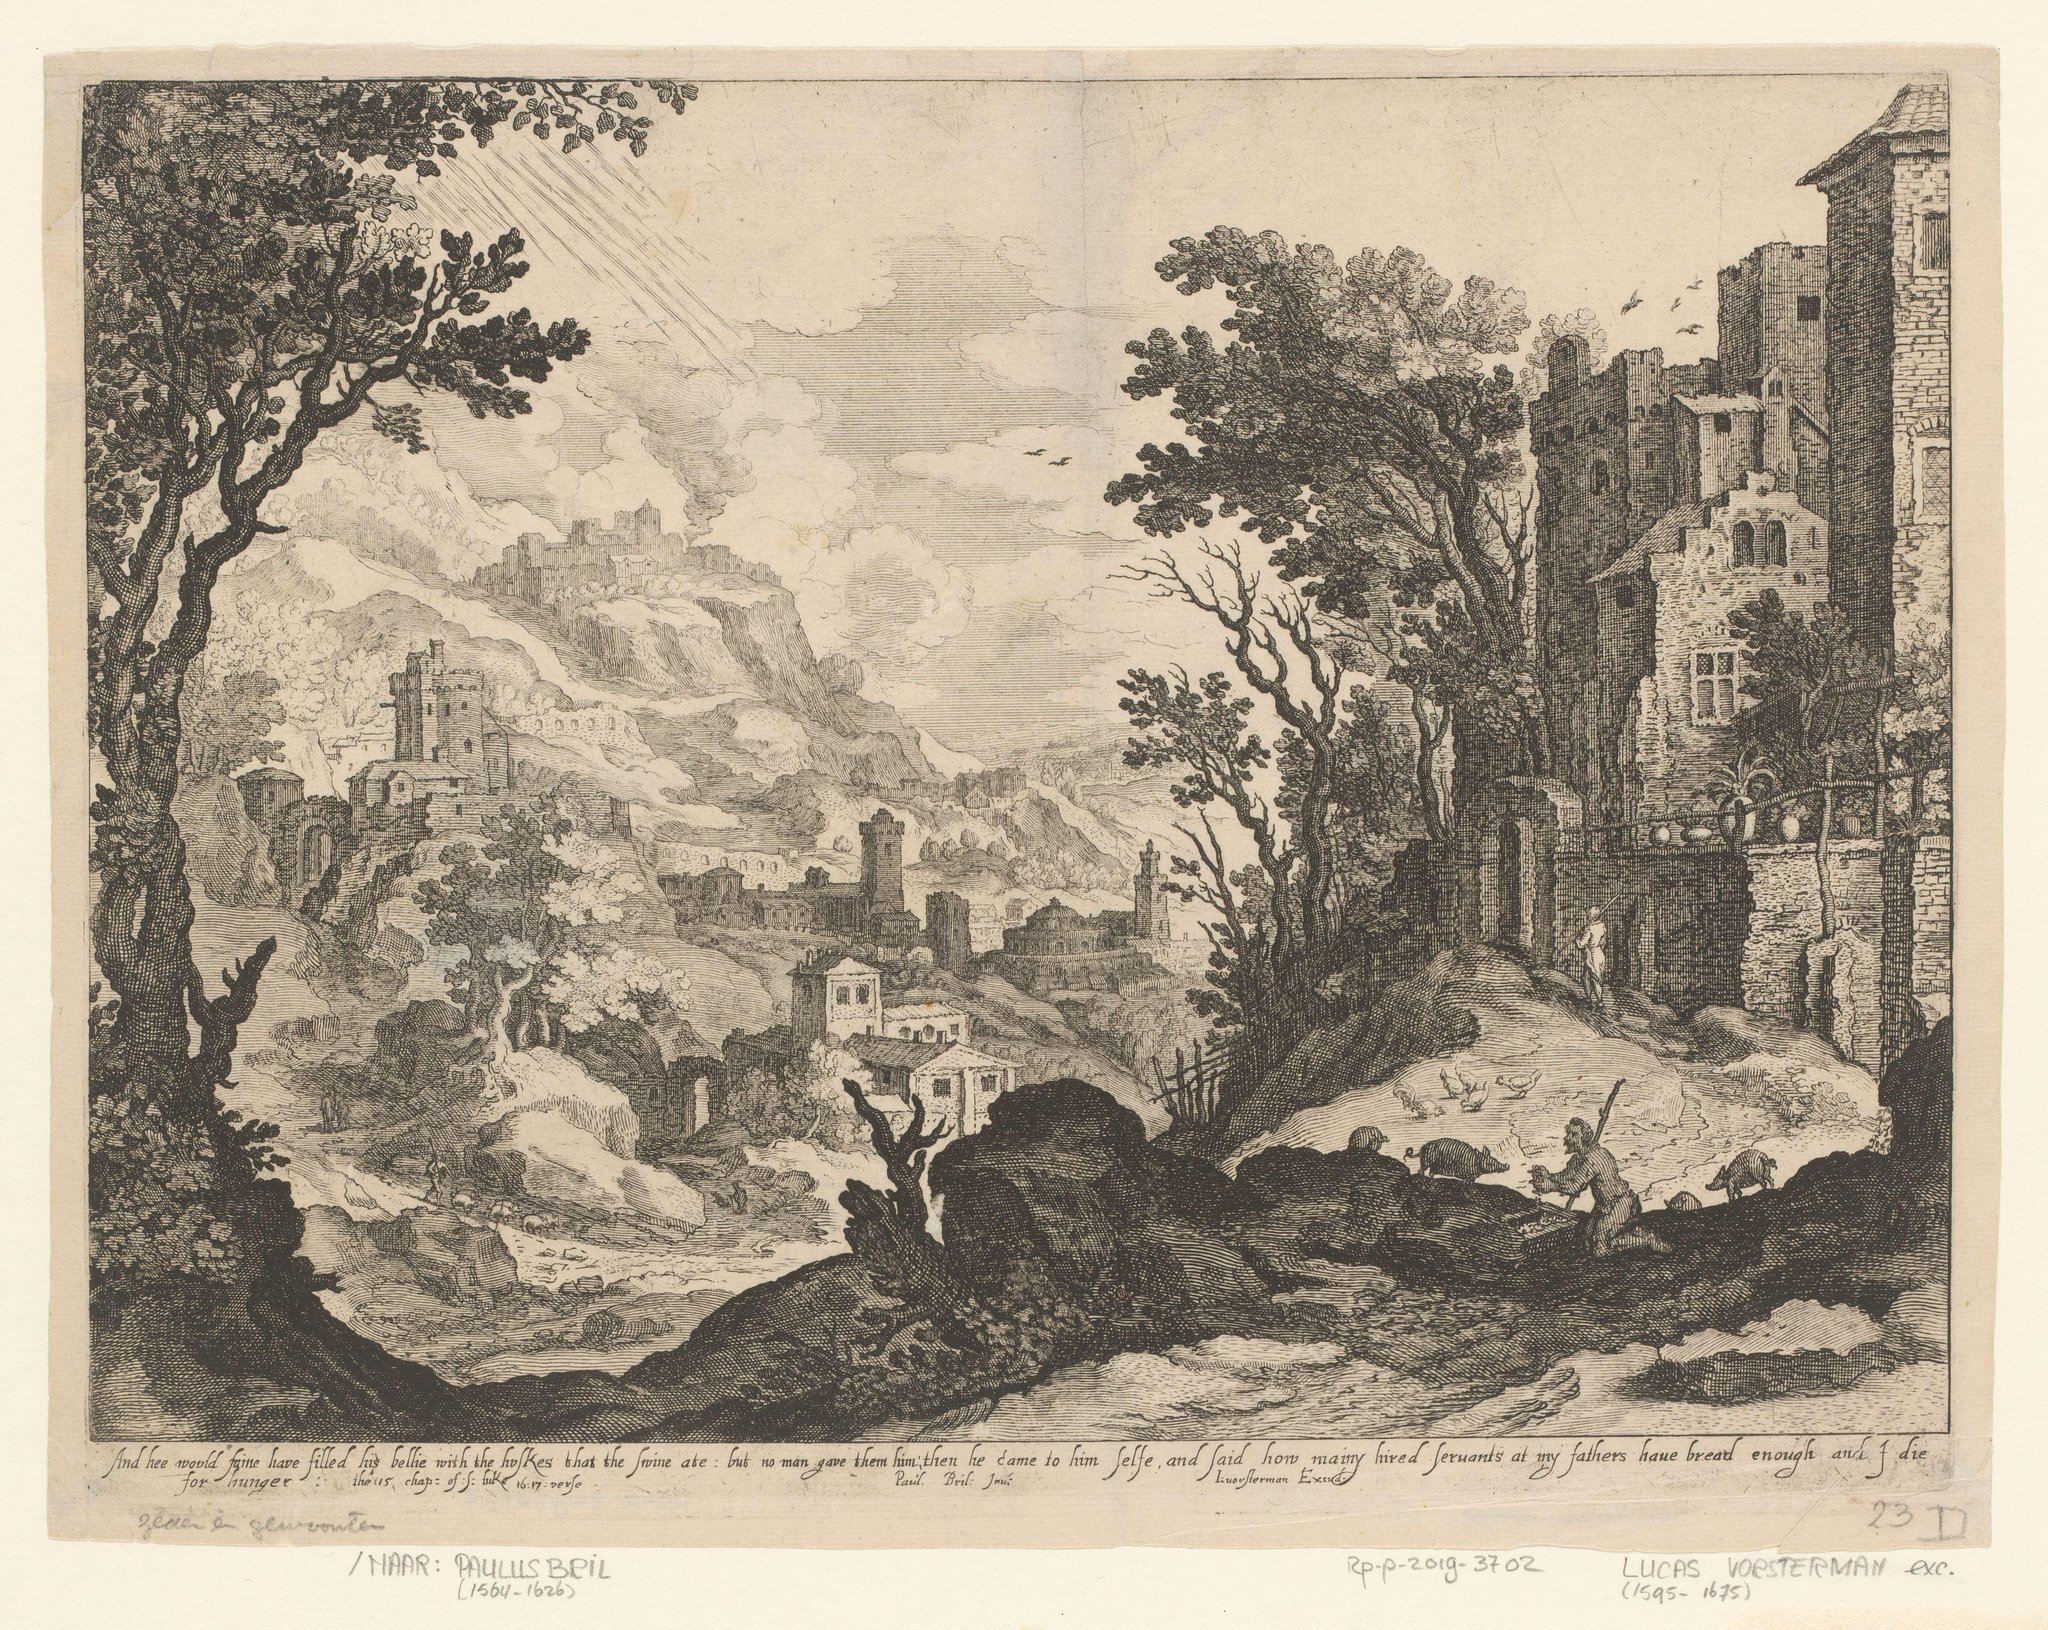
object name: print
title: Landschap met de verloren zoon als zwijnenhoeder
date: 1650-1655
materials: paper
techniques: engraving, etching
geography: antwerp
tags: the parable of the prodigal son (luke 15:11-32)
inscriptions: collector's mark: Lugt 2228, collector's mark: Lugt 240